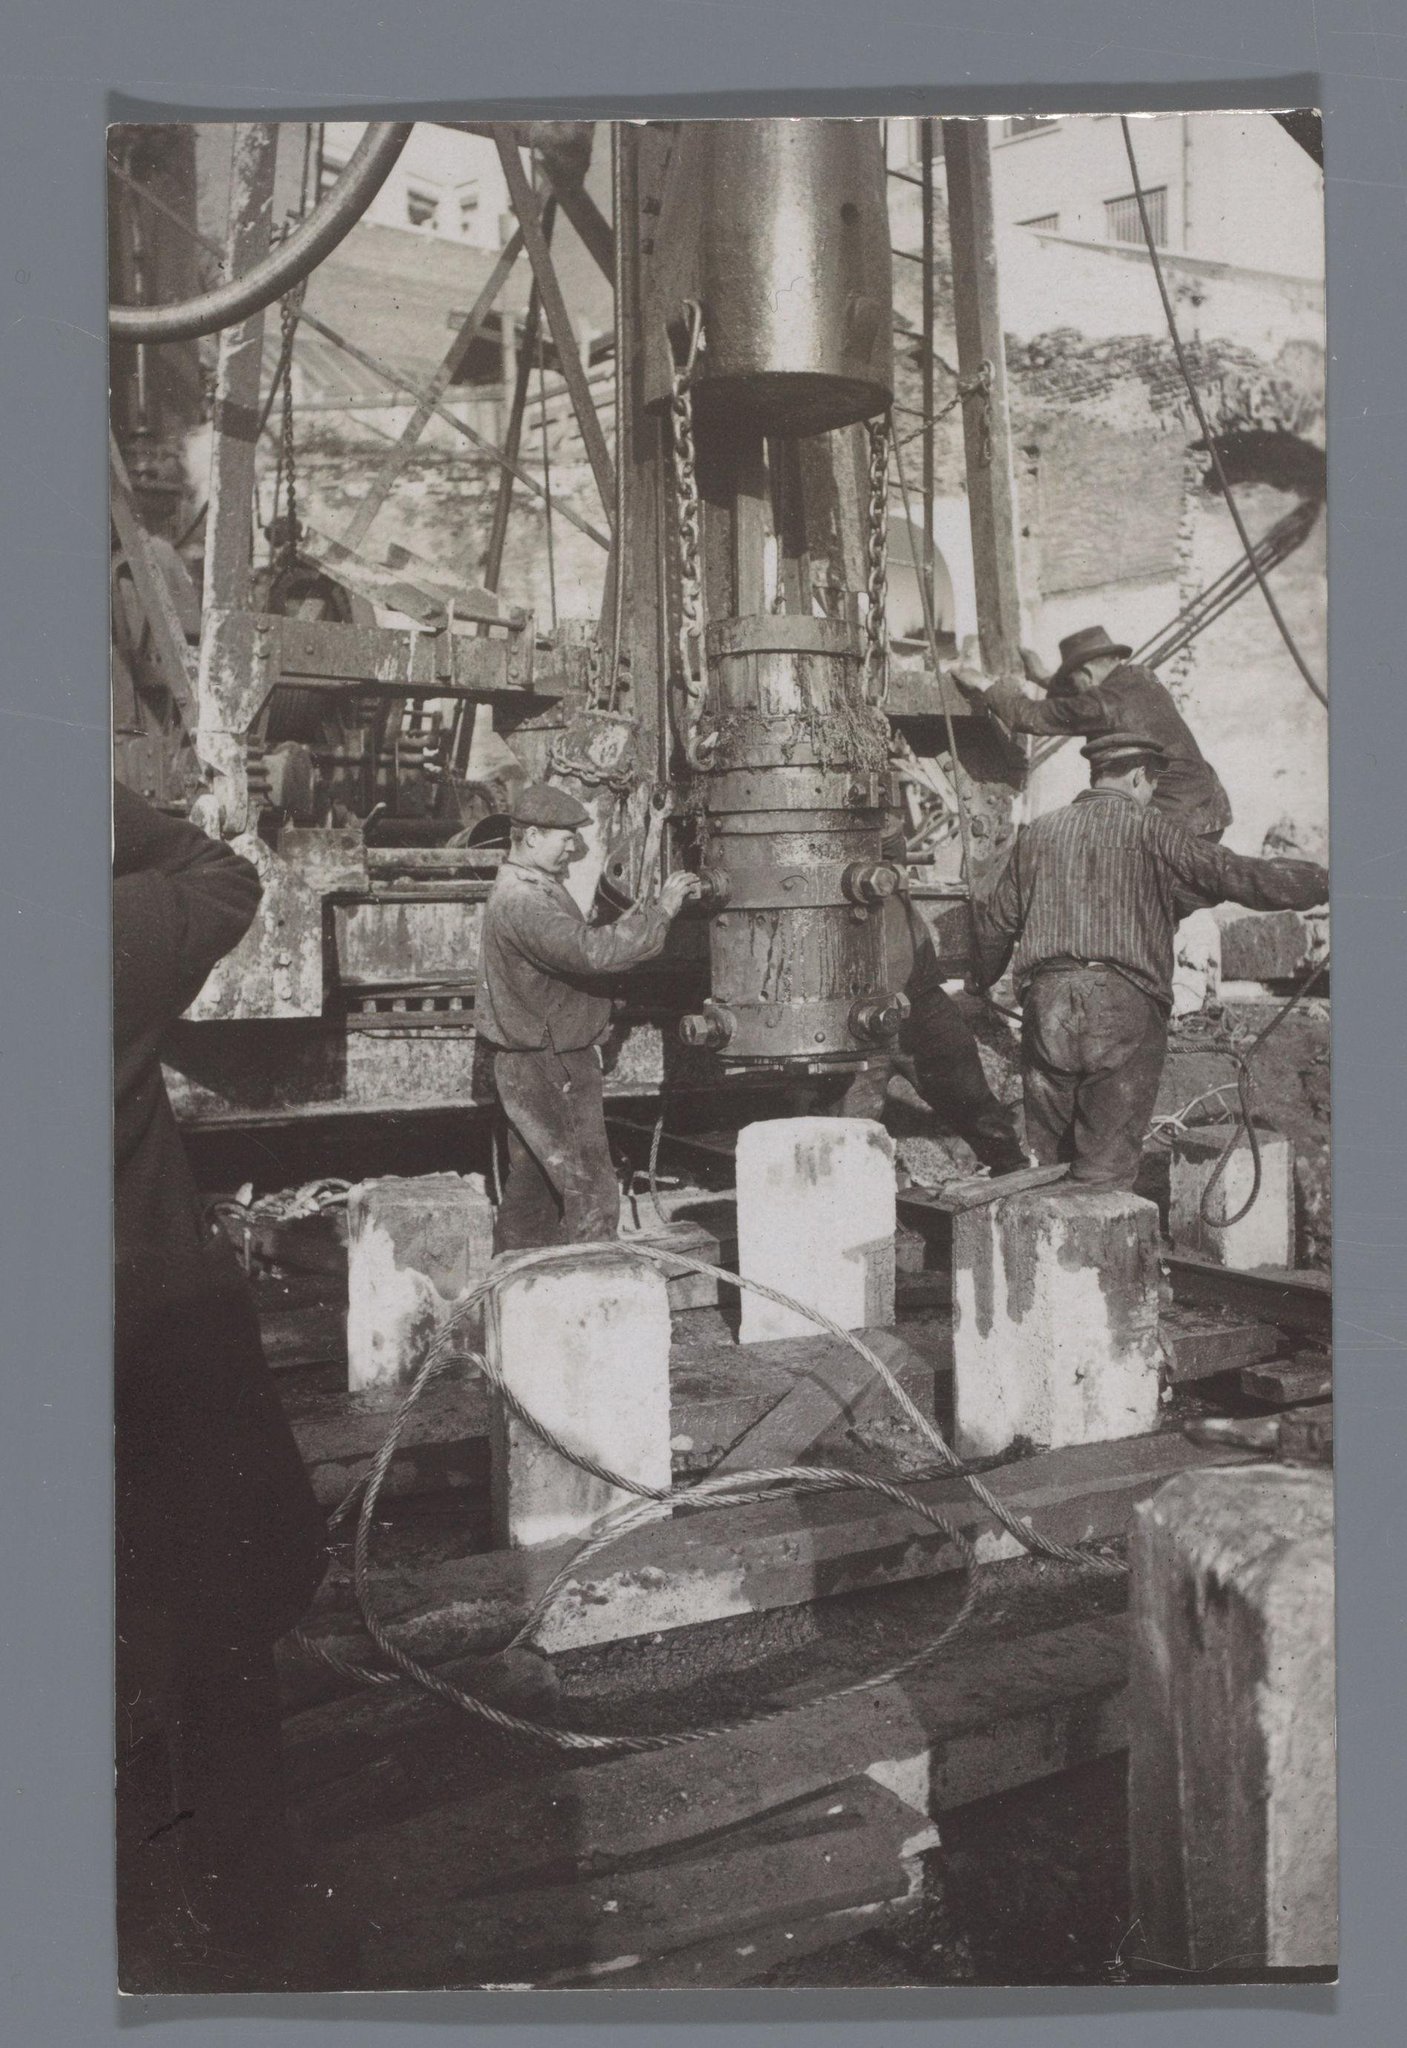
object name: photograph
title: Arbeiders bij een heistelling tijdens bouwwerkzaamheden in Brussel, België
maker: wesseling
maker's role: fotograaf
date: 1912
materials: photographic support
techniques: gelatin silver print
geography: brussels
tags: ramming, driving piles (~ building activities), building-site, brussels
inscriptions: inscription: ‘Brussel’, signature and date: ‘11/2 1912 / Wesseling’